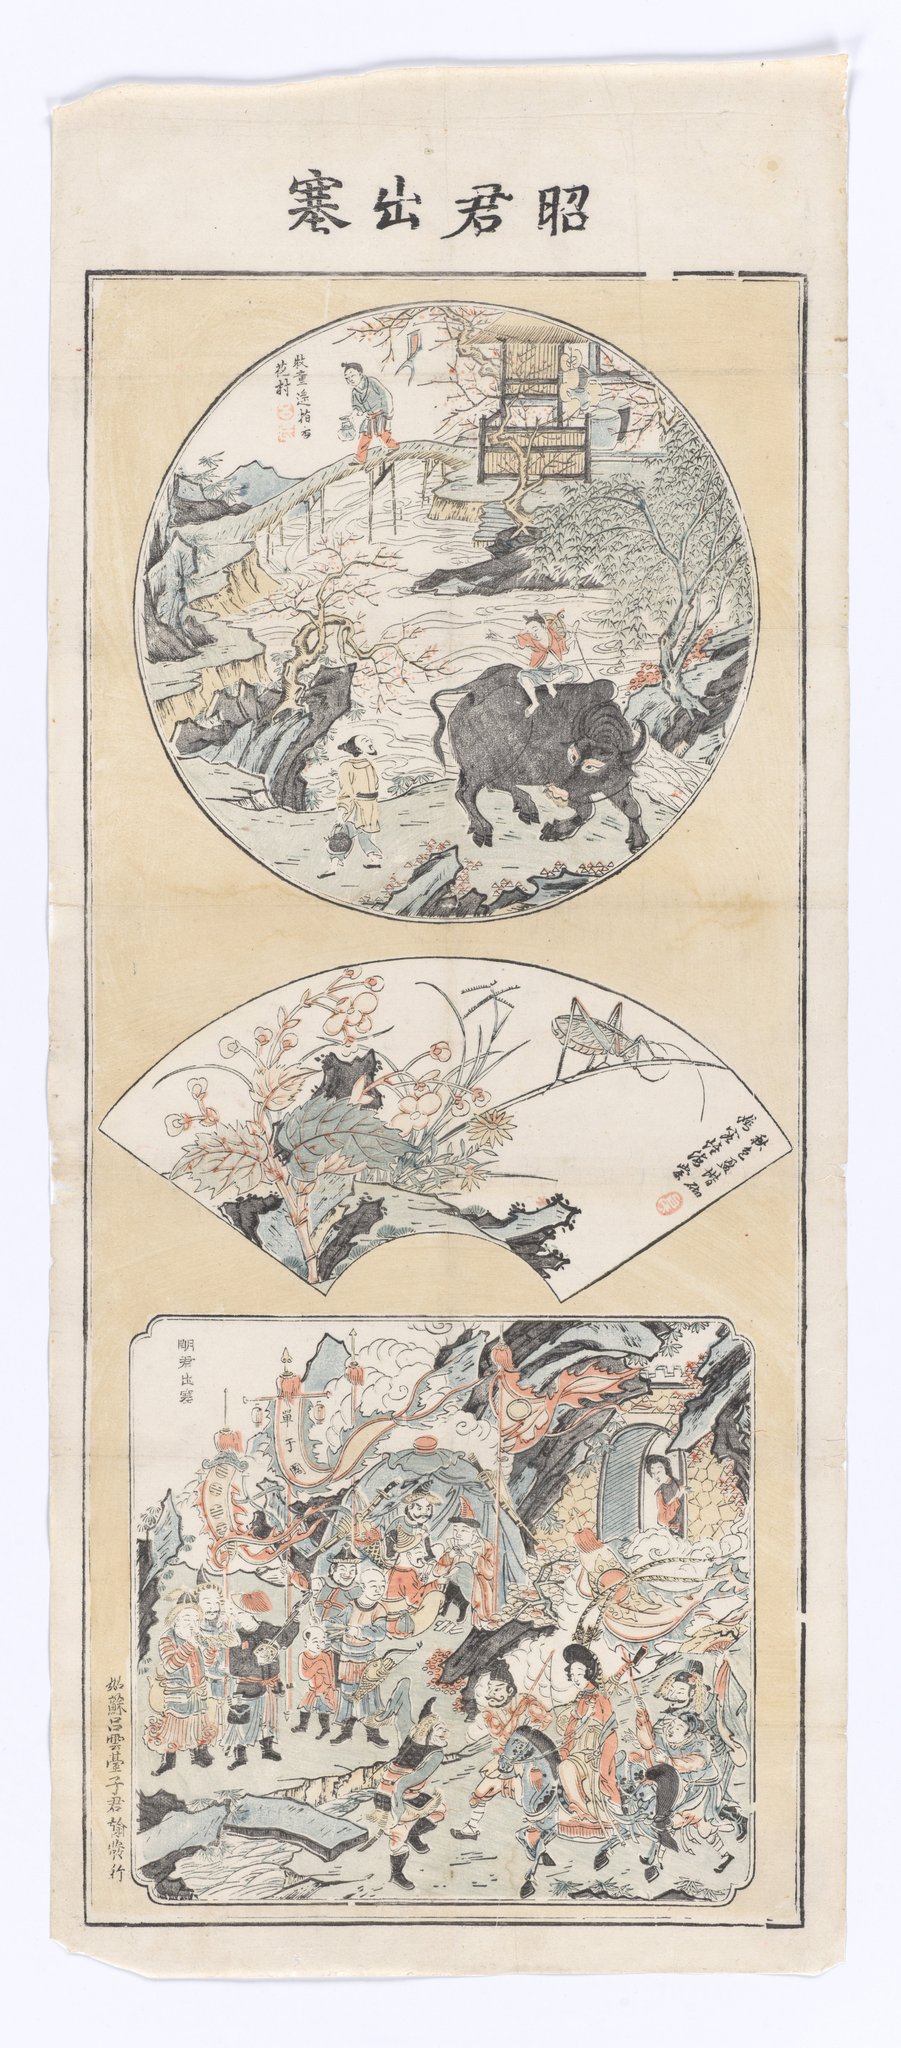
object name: print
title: Zhaojun Leaves for the North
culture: chinese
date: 1662-1722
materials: ink, paper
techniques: hand coloring, woodblock print